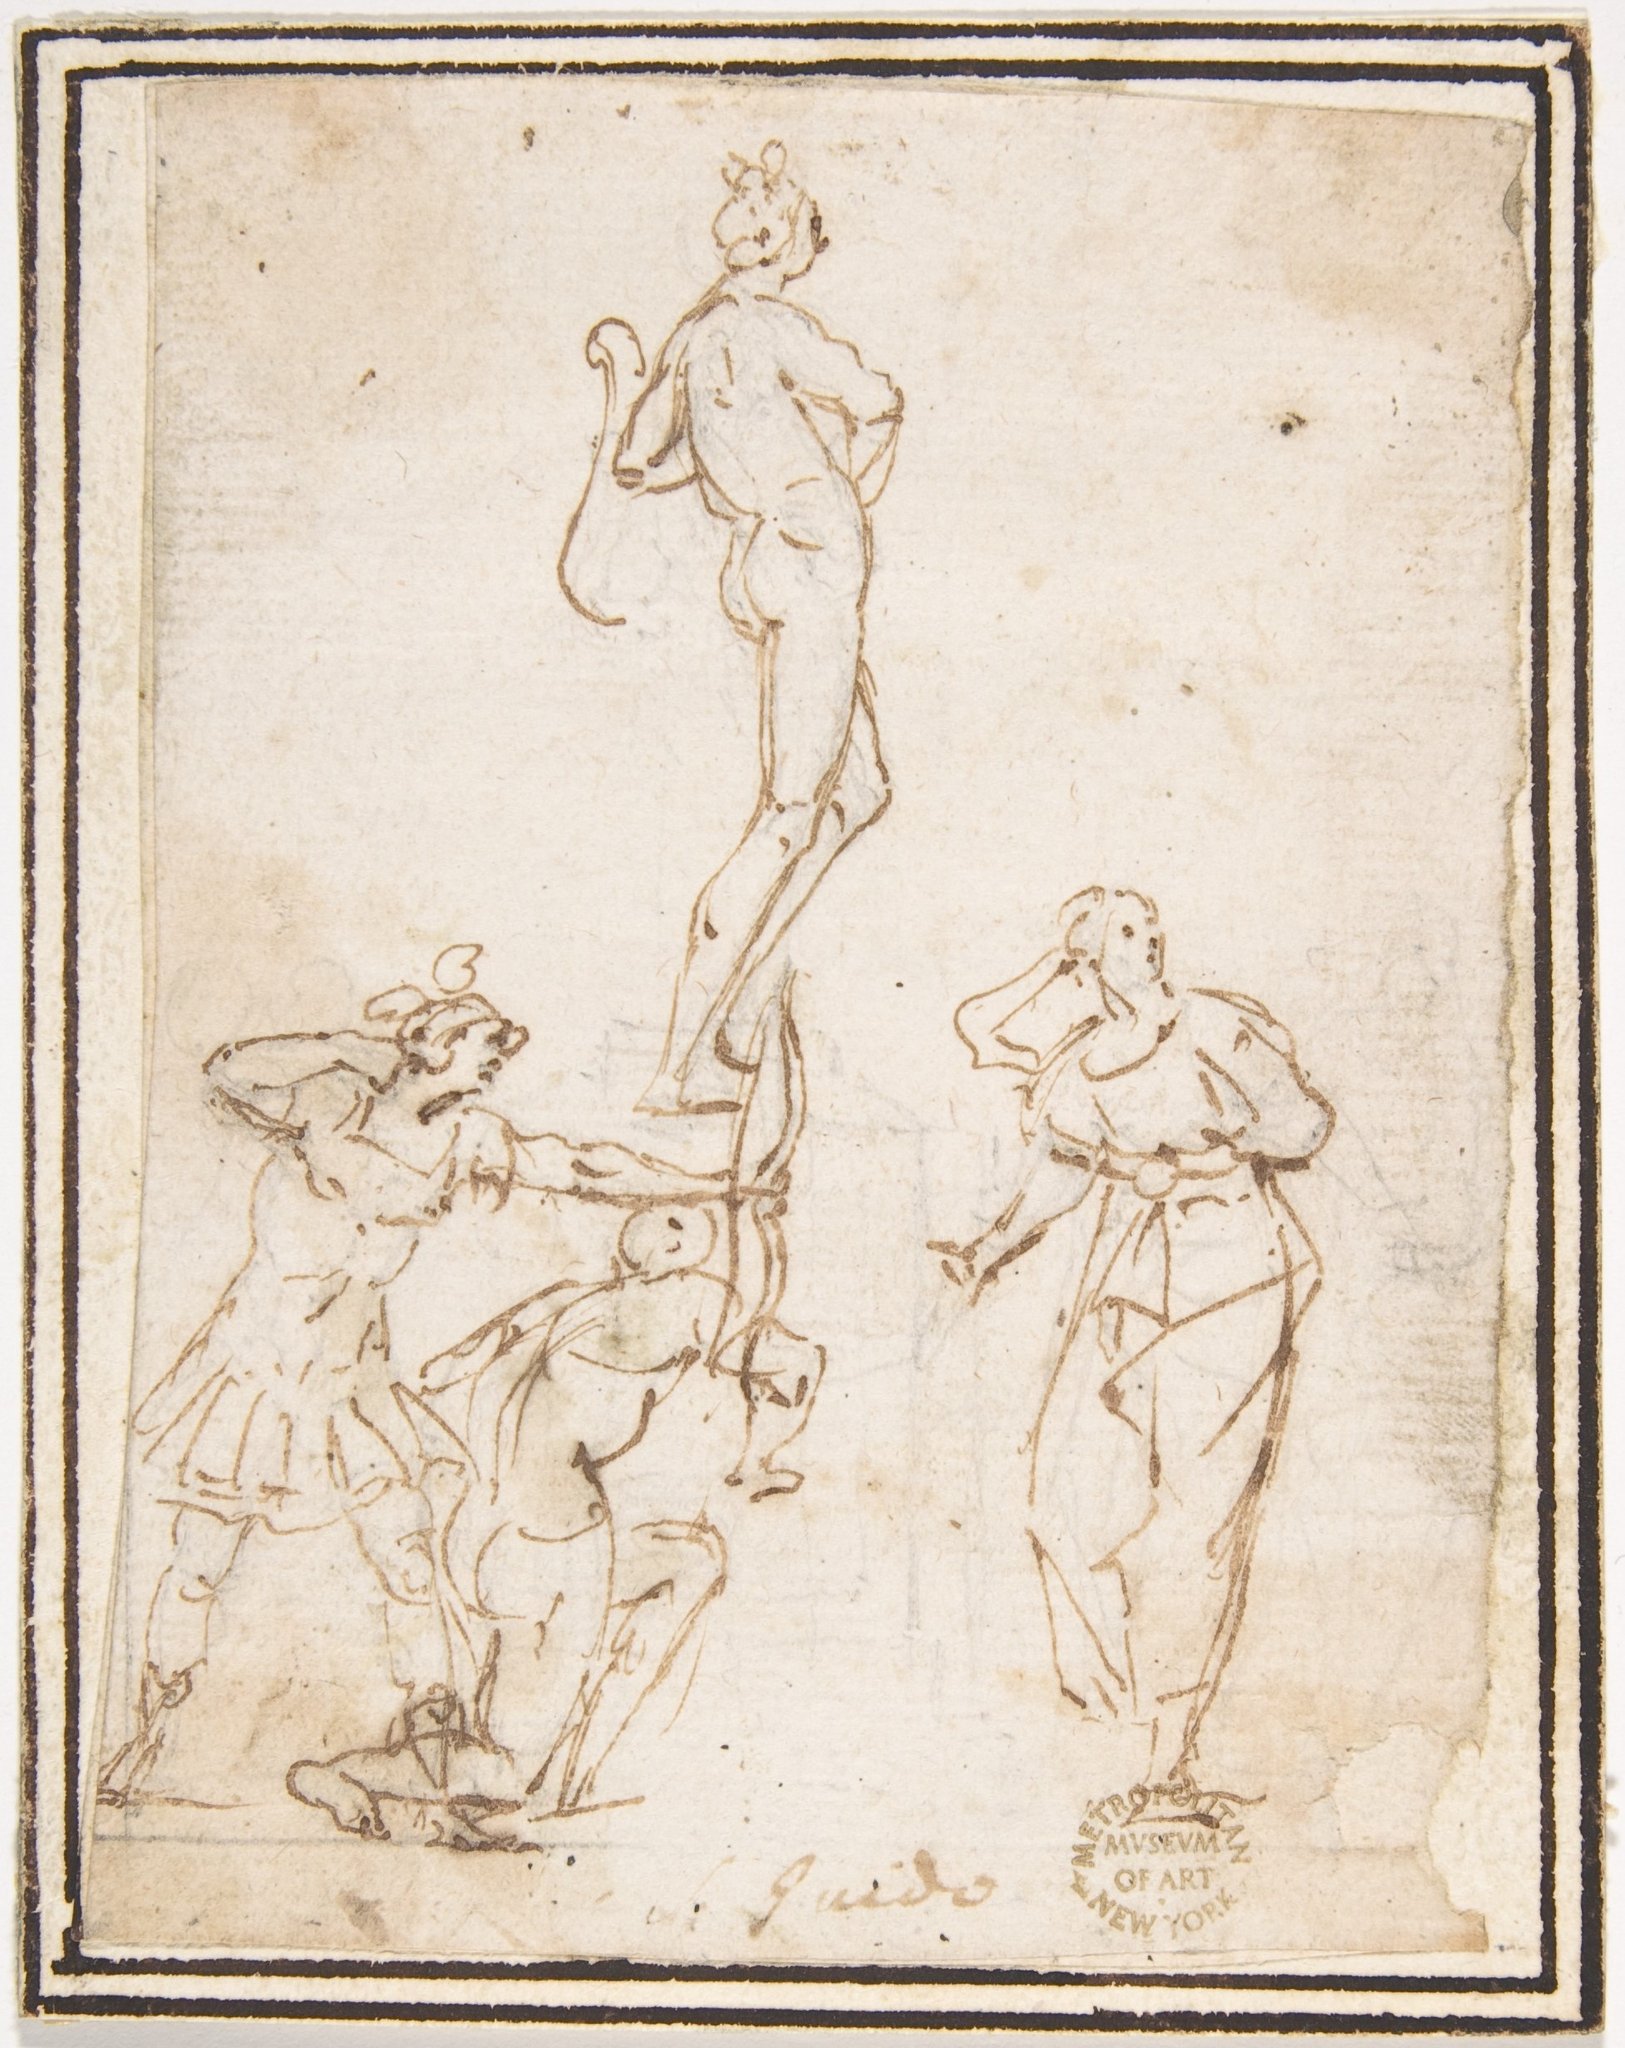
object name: drawing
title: Four Figures Studies, One of a Standing Archer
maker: francesco allegrini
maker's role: artist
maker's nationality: italian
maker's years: 1615-1679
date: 1624-1663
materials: ink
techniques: pen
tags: human figures